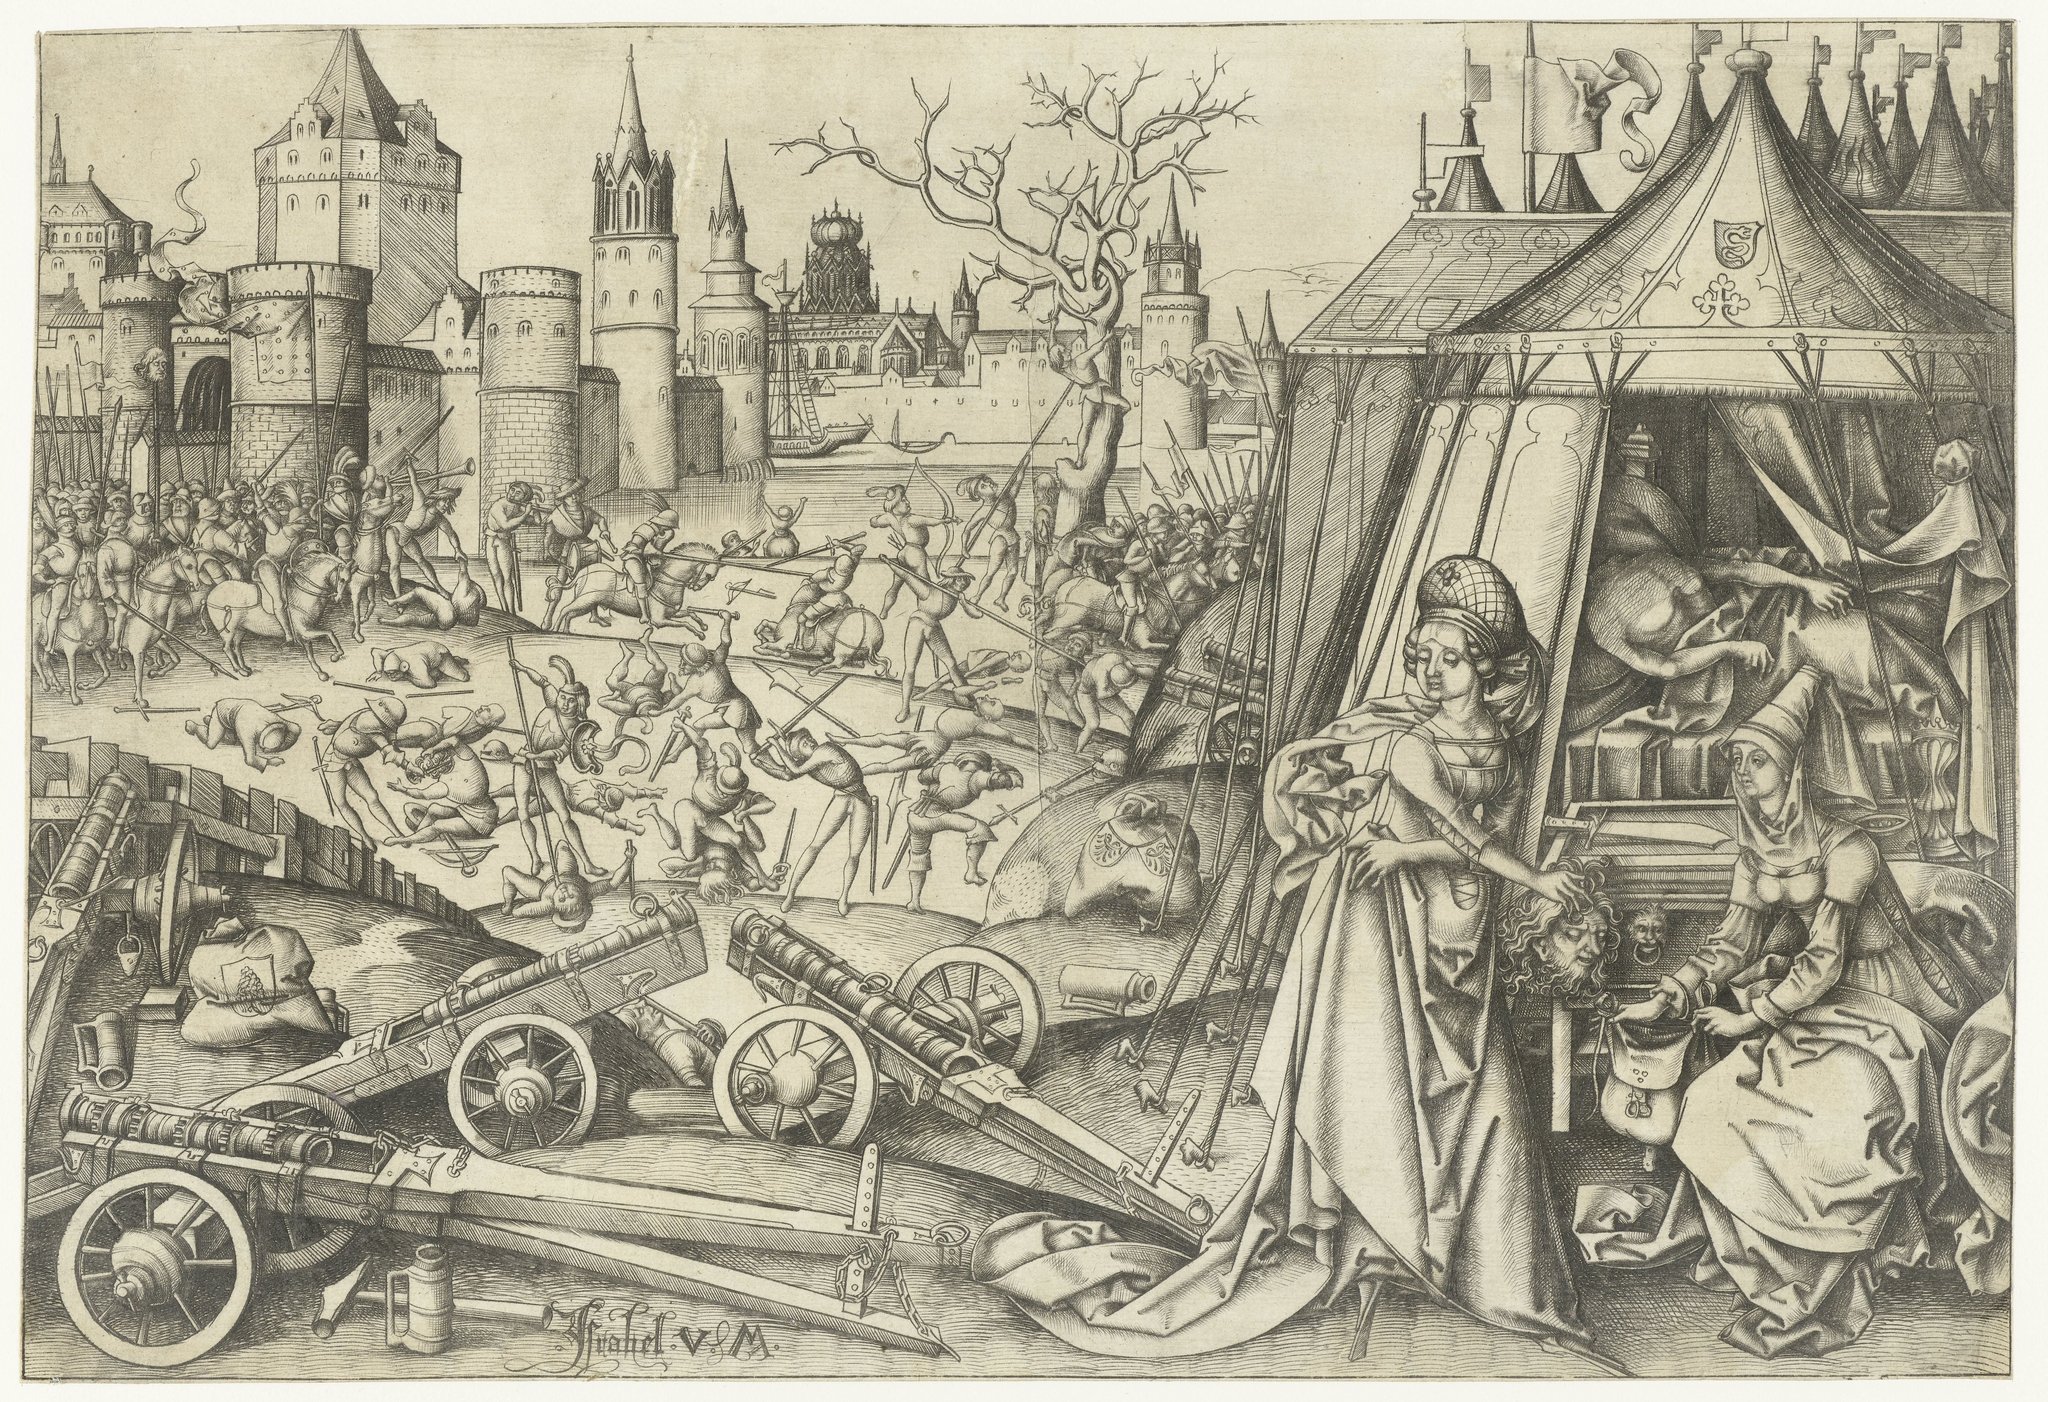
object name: print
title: Judith met het hoofd van Holofernes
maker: israhel van meckenem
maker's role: print maker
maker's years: 1440-1517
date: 1455-1503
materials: paper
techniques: engraving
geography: bocholt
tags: judith and her maidservant put holofernes' head in a sack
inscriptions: collector's mark: Lugt 2228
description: Bij een tent in een legerkamp doet Judith het zojuist afgehakte hoofd van Holofernes in een tas, die haar dienstmaagd voor haar openhoudt. In de tent is op bed nog het onthoofde lichaam te zien. Op de achtergrond strijdende soldaten bij een burcht.